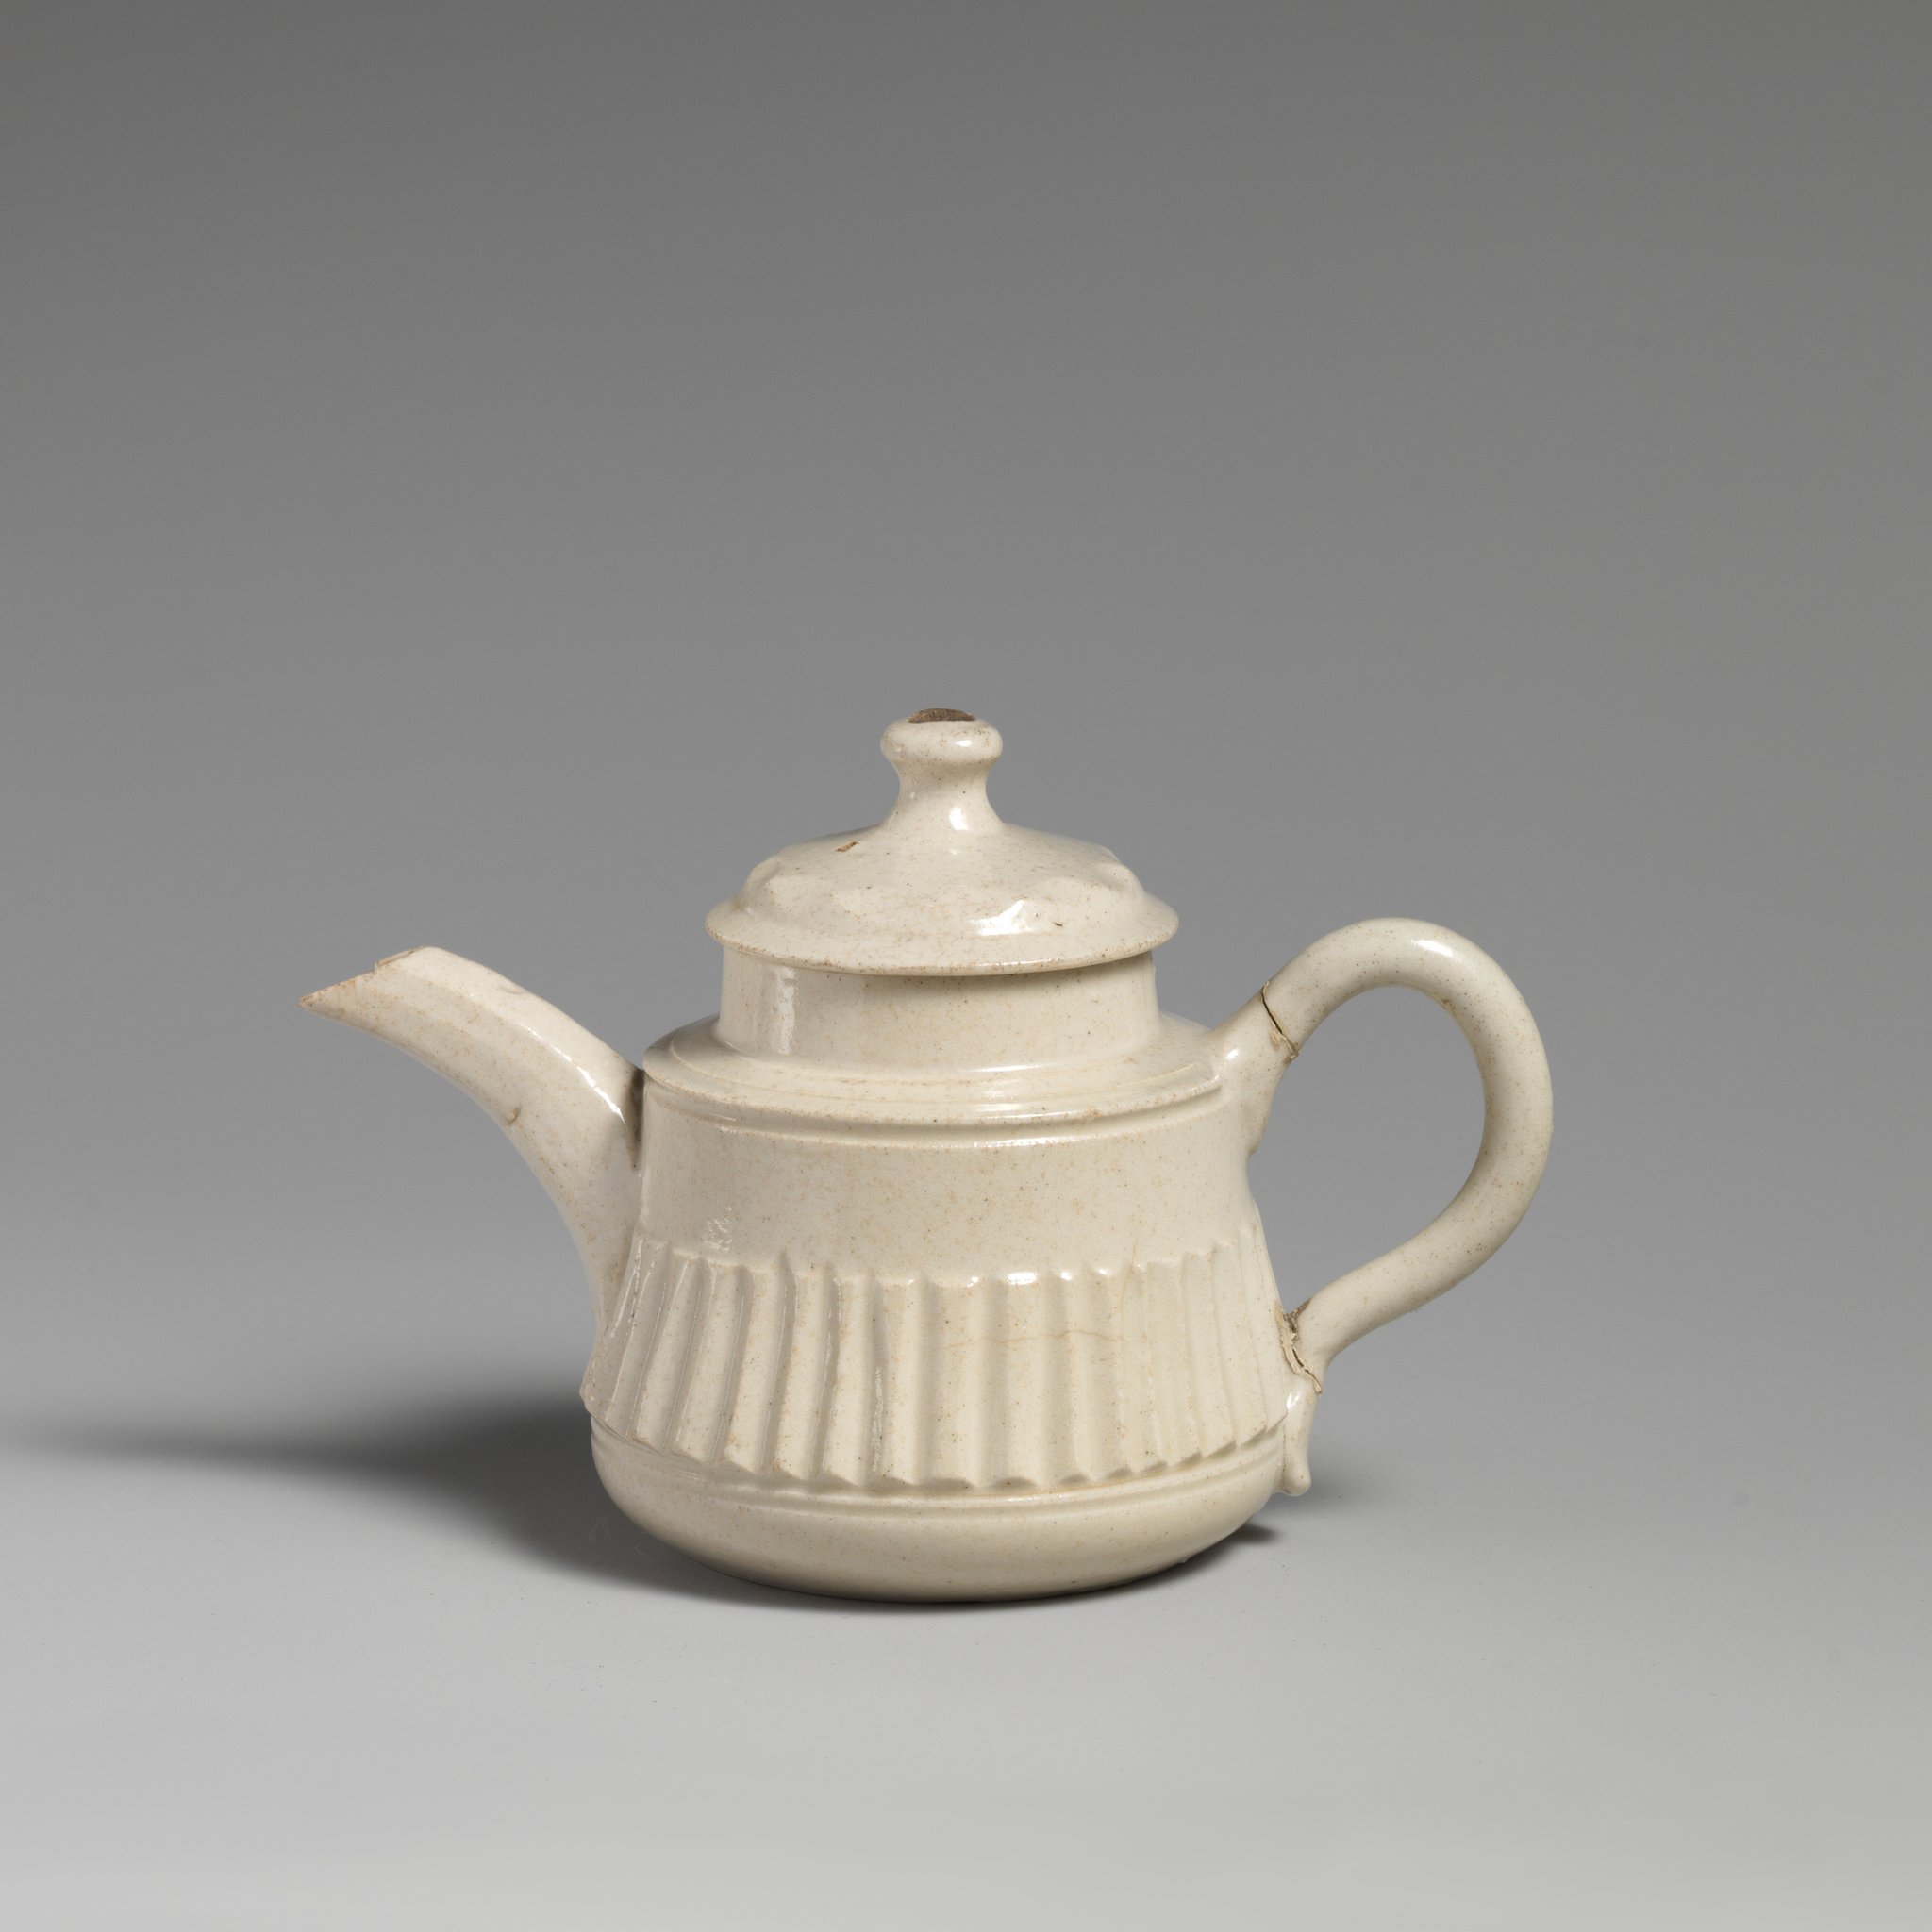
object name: teapot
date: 1750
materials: stoneware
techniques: salt glaze